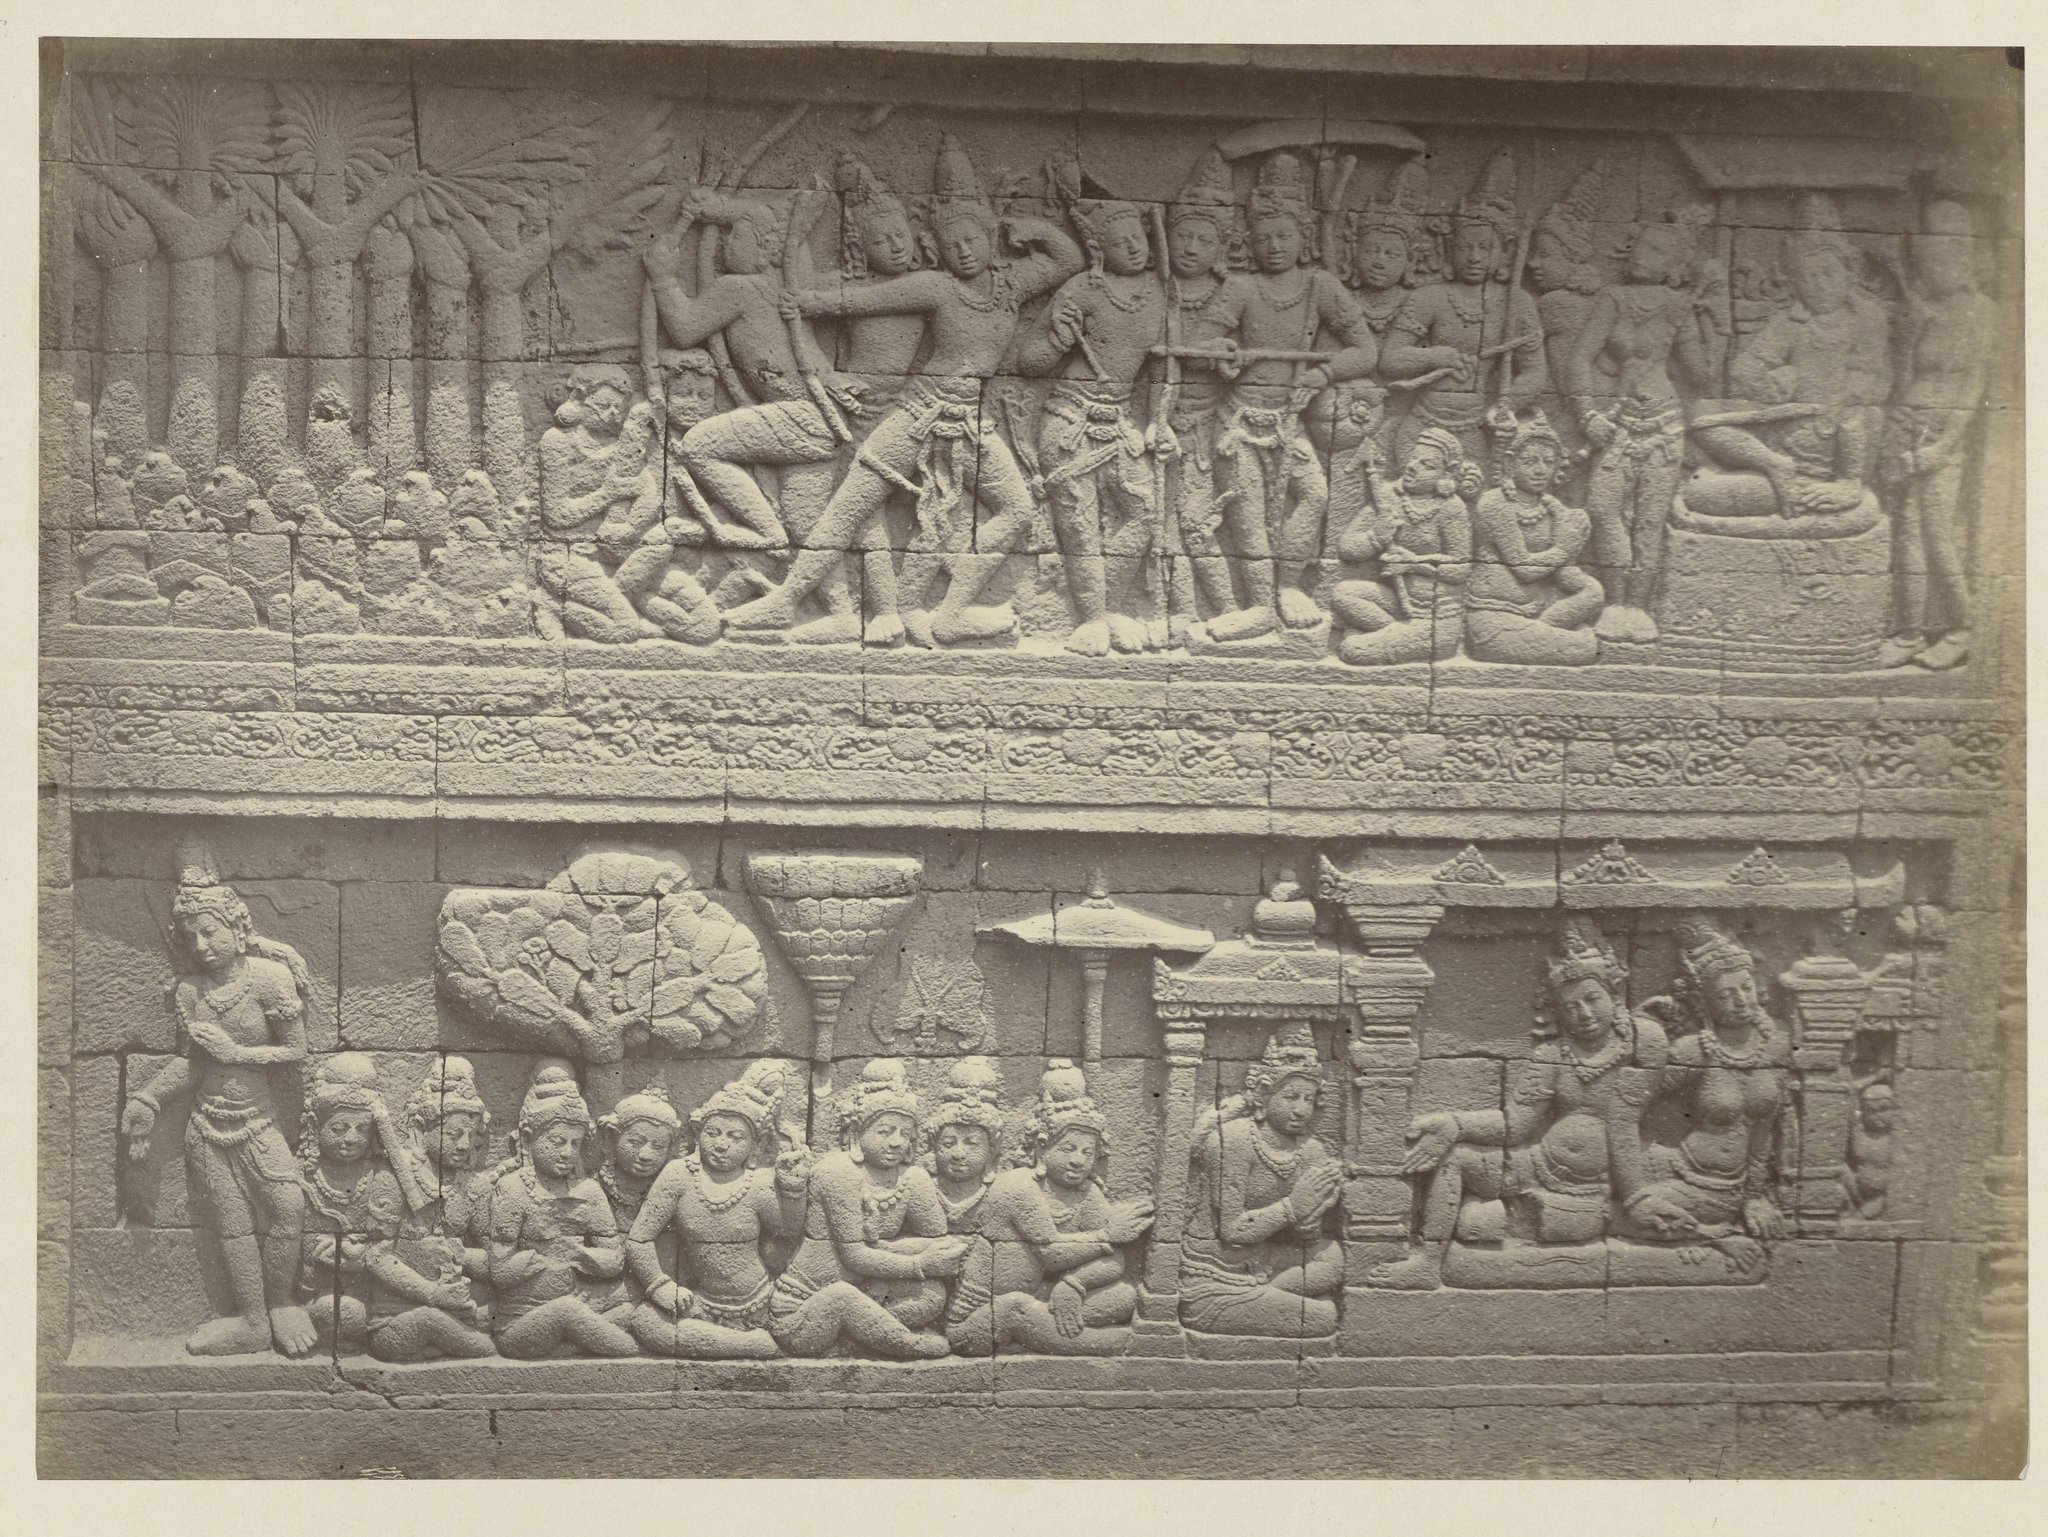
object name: photograph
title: Idem 2e gaanderij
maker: isidore kinsbergen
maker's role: fotograaf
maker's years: 1821-1905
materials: cardboard, paper, photographic support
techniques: albumen print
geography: java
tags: borobudur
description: Gallery I, main wall, west side 29 (top): Relief 1a-49, Lalitavistara relief, Siddhartha engaged in an archery competition, sending his arrow through seven trees. 30 (bottom): relief 1b-49, Avadana relief, Mandhatar story, Mandhatar wishes to rule over the gods Borobudur village, Magelang district, Central Java province, 778-824 AD.